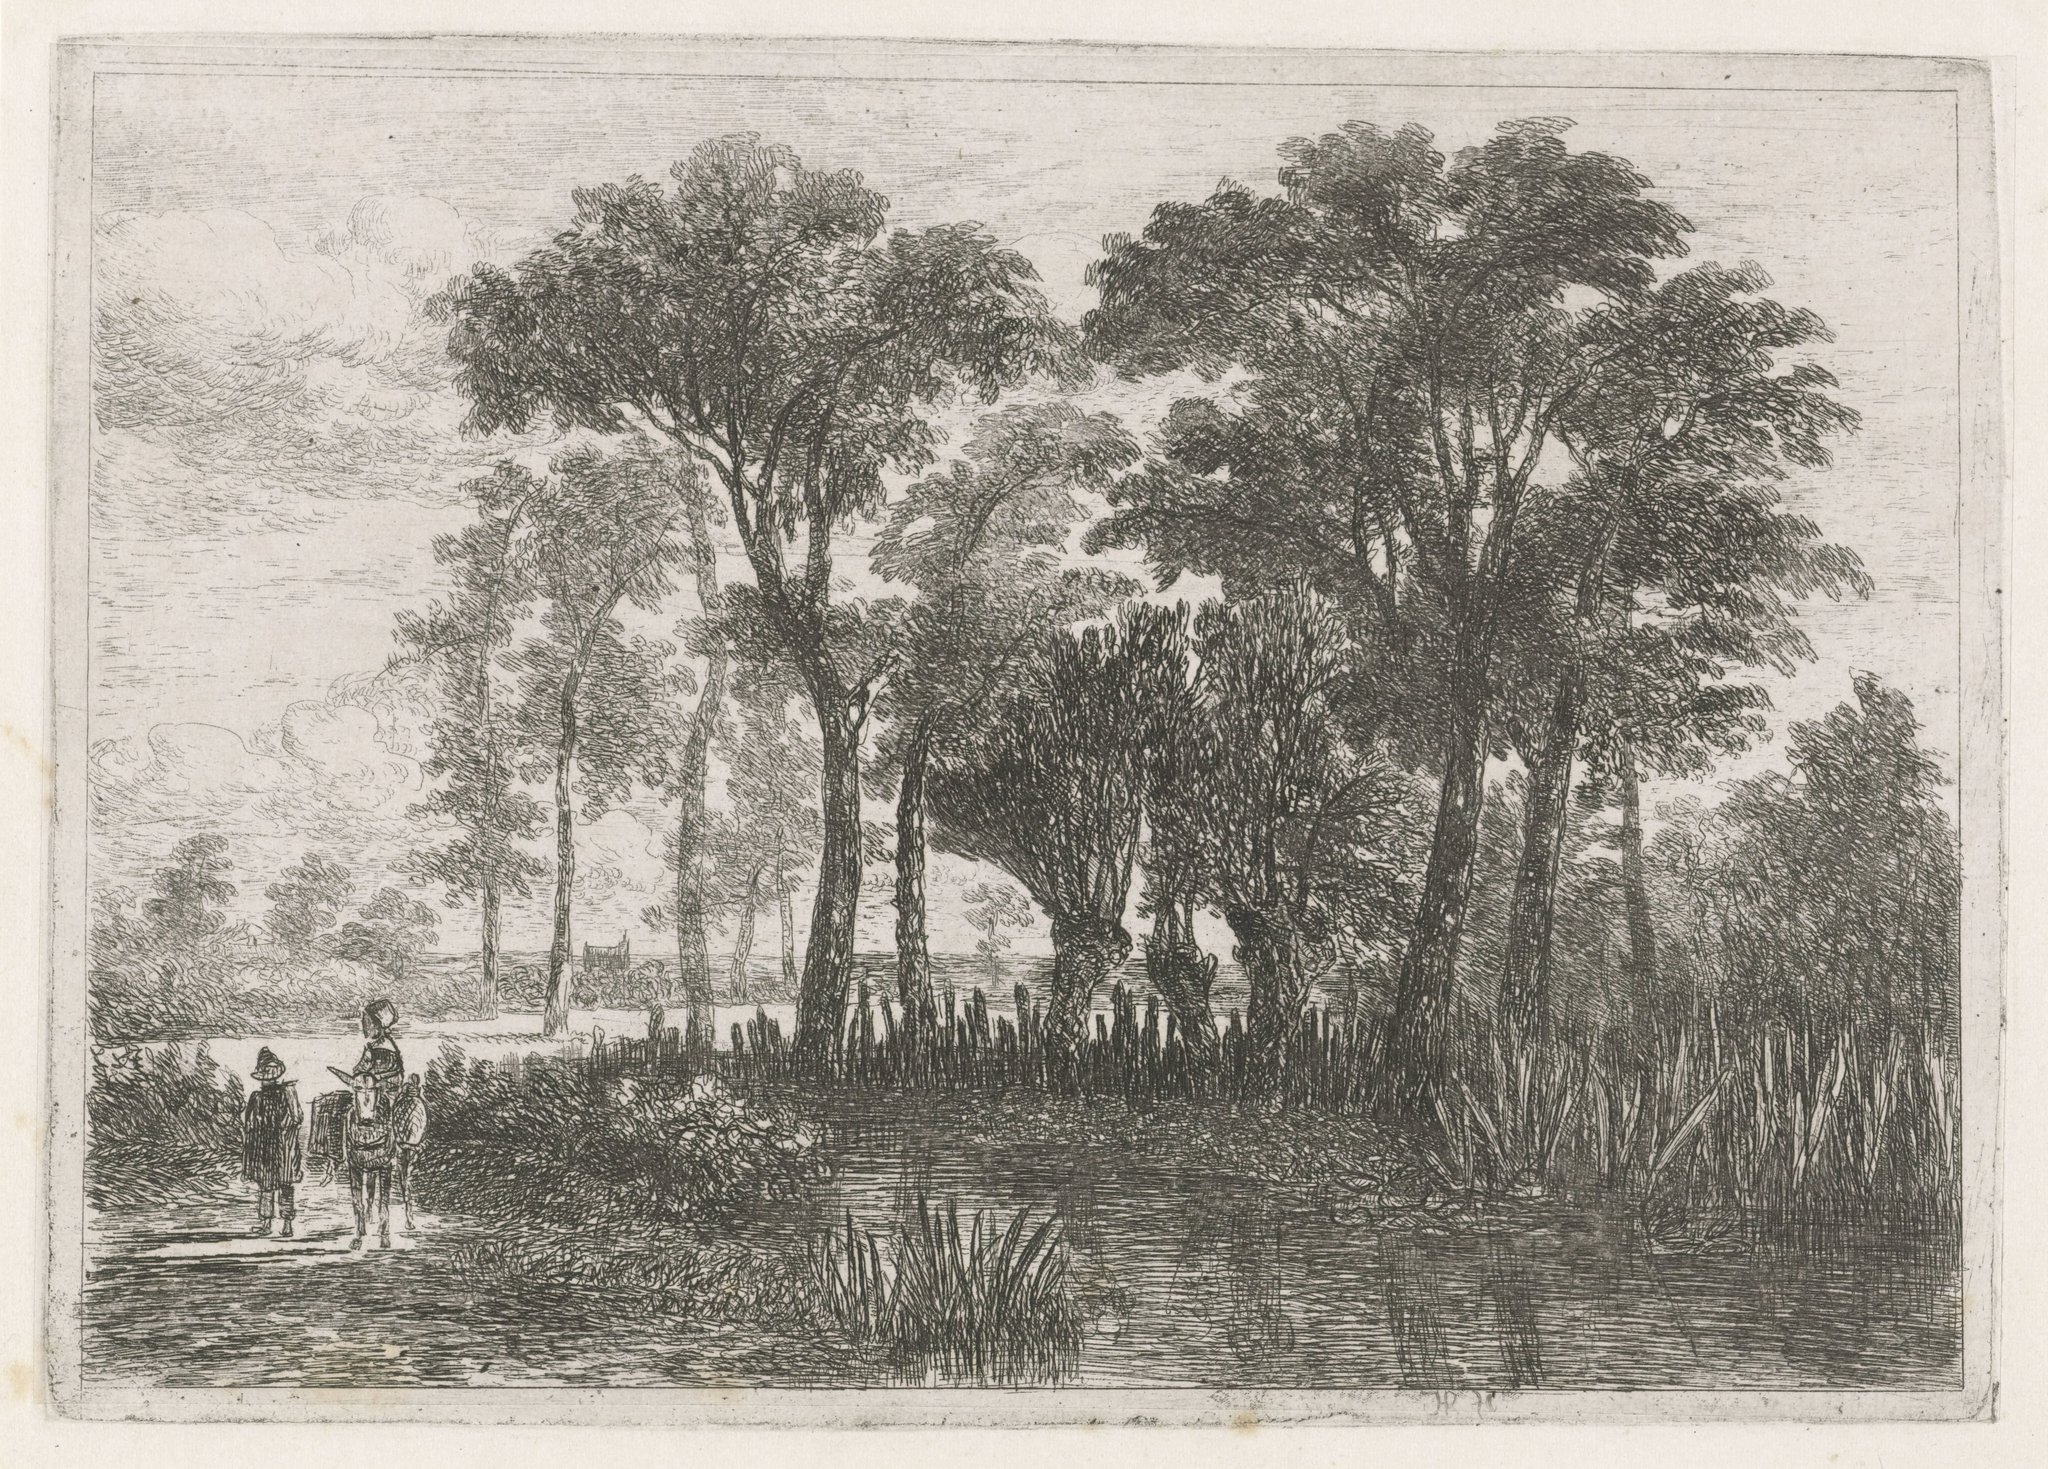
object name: print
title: Boslandschap met een vrouw op een ezel en een wandelaar bij een ven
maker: hermanus jan hendrik van rijkelijkhuysen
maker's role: painter, print maker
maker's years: 1813-1883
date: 1823-1883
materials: paper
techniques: drypoint, etching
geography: utrecht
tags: trees, fen, du. 'ven', donkey-riding (on the beach)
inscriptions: collector's mark: Lugt 1485, collector's mark: Lugt 2228